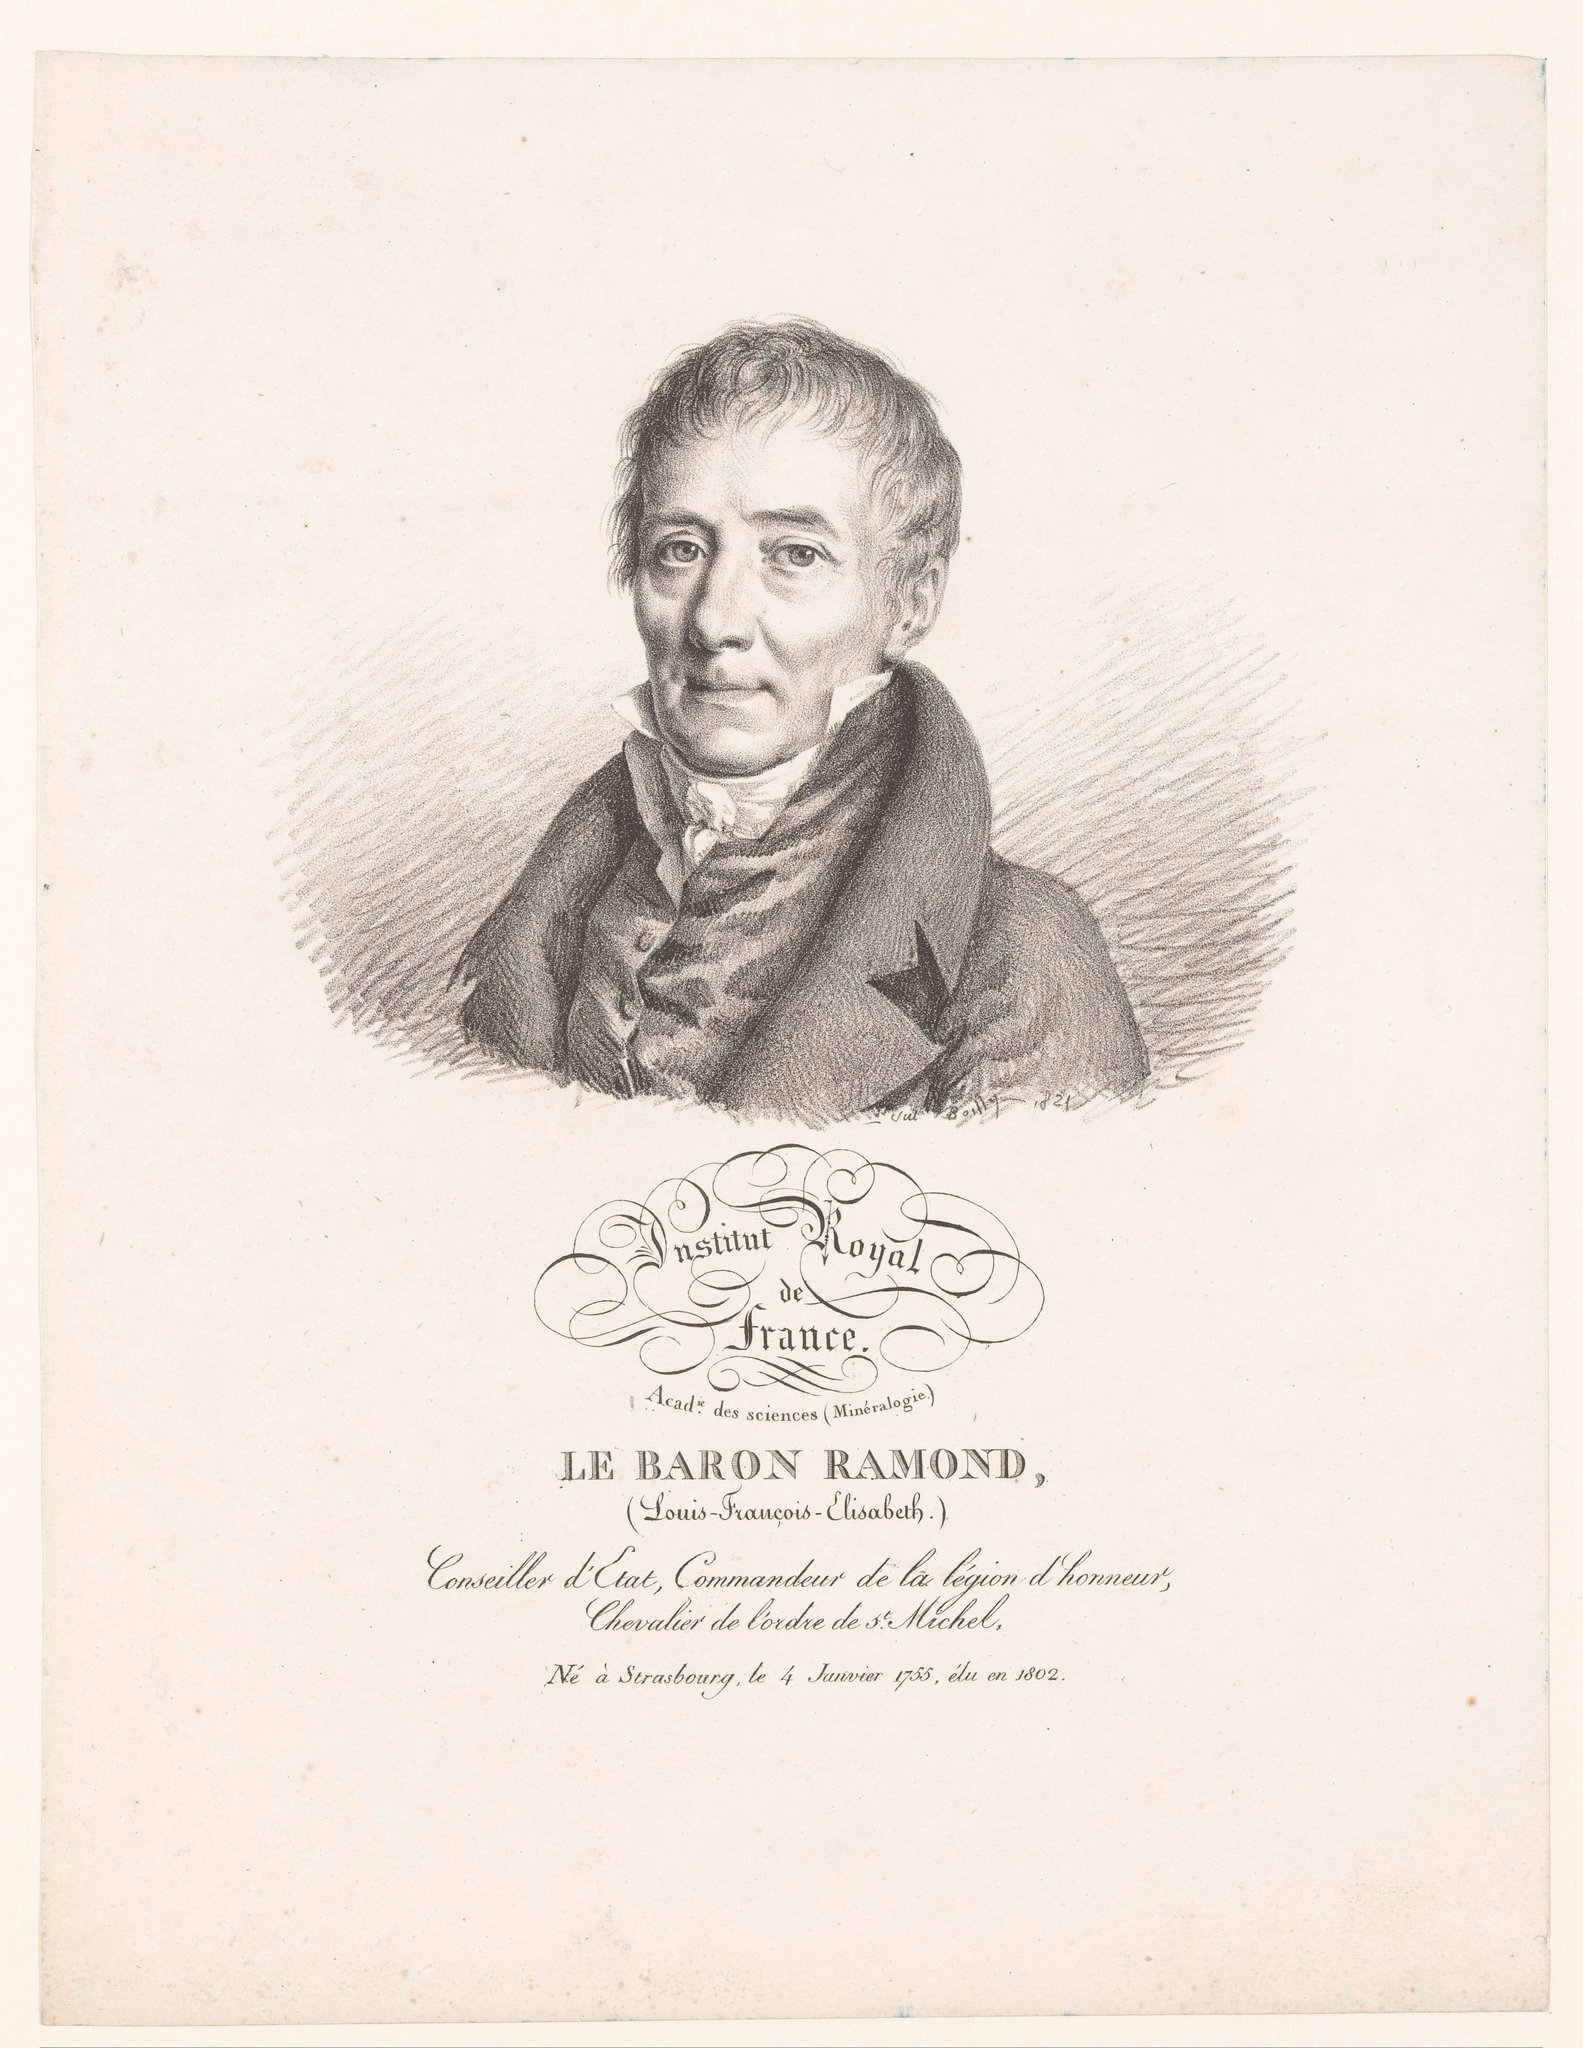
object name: print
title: Leden van het Institut Royal de France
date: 1821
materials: paper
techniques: lithograph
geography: paris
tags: paris, politician, historical persons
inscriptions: collector's mark: Lugt 2228a